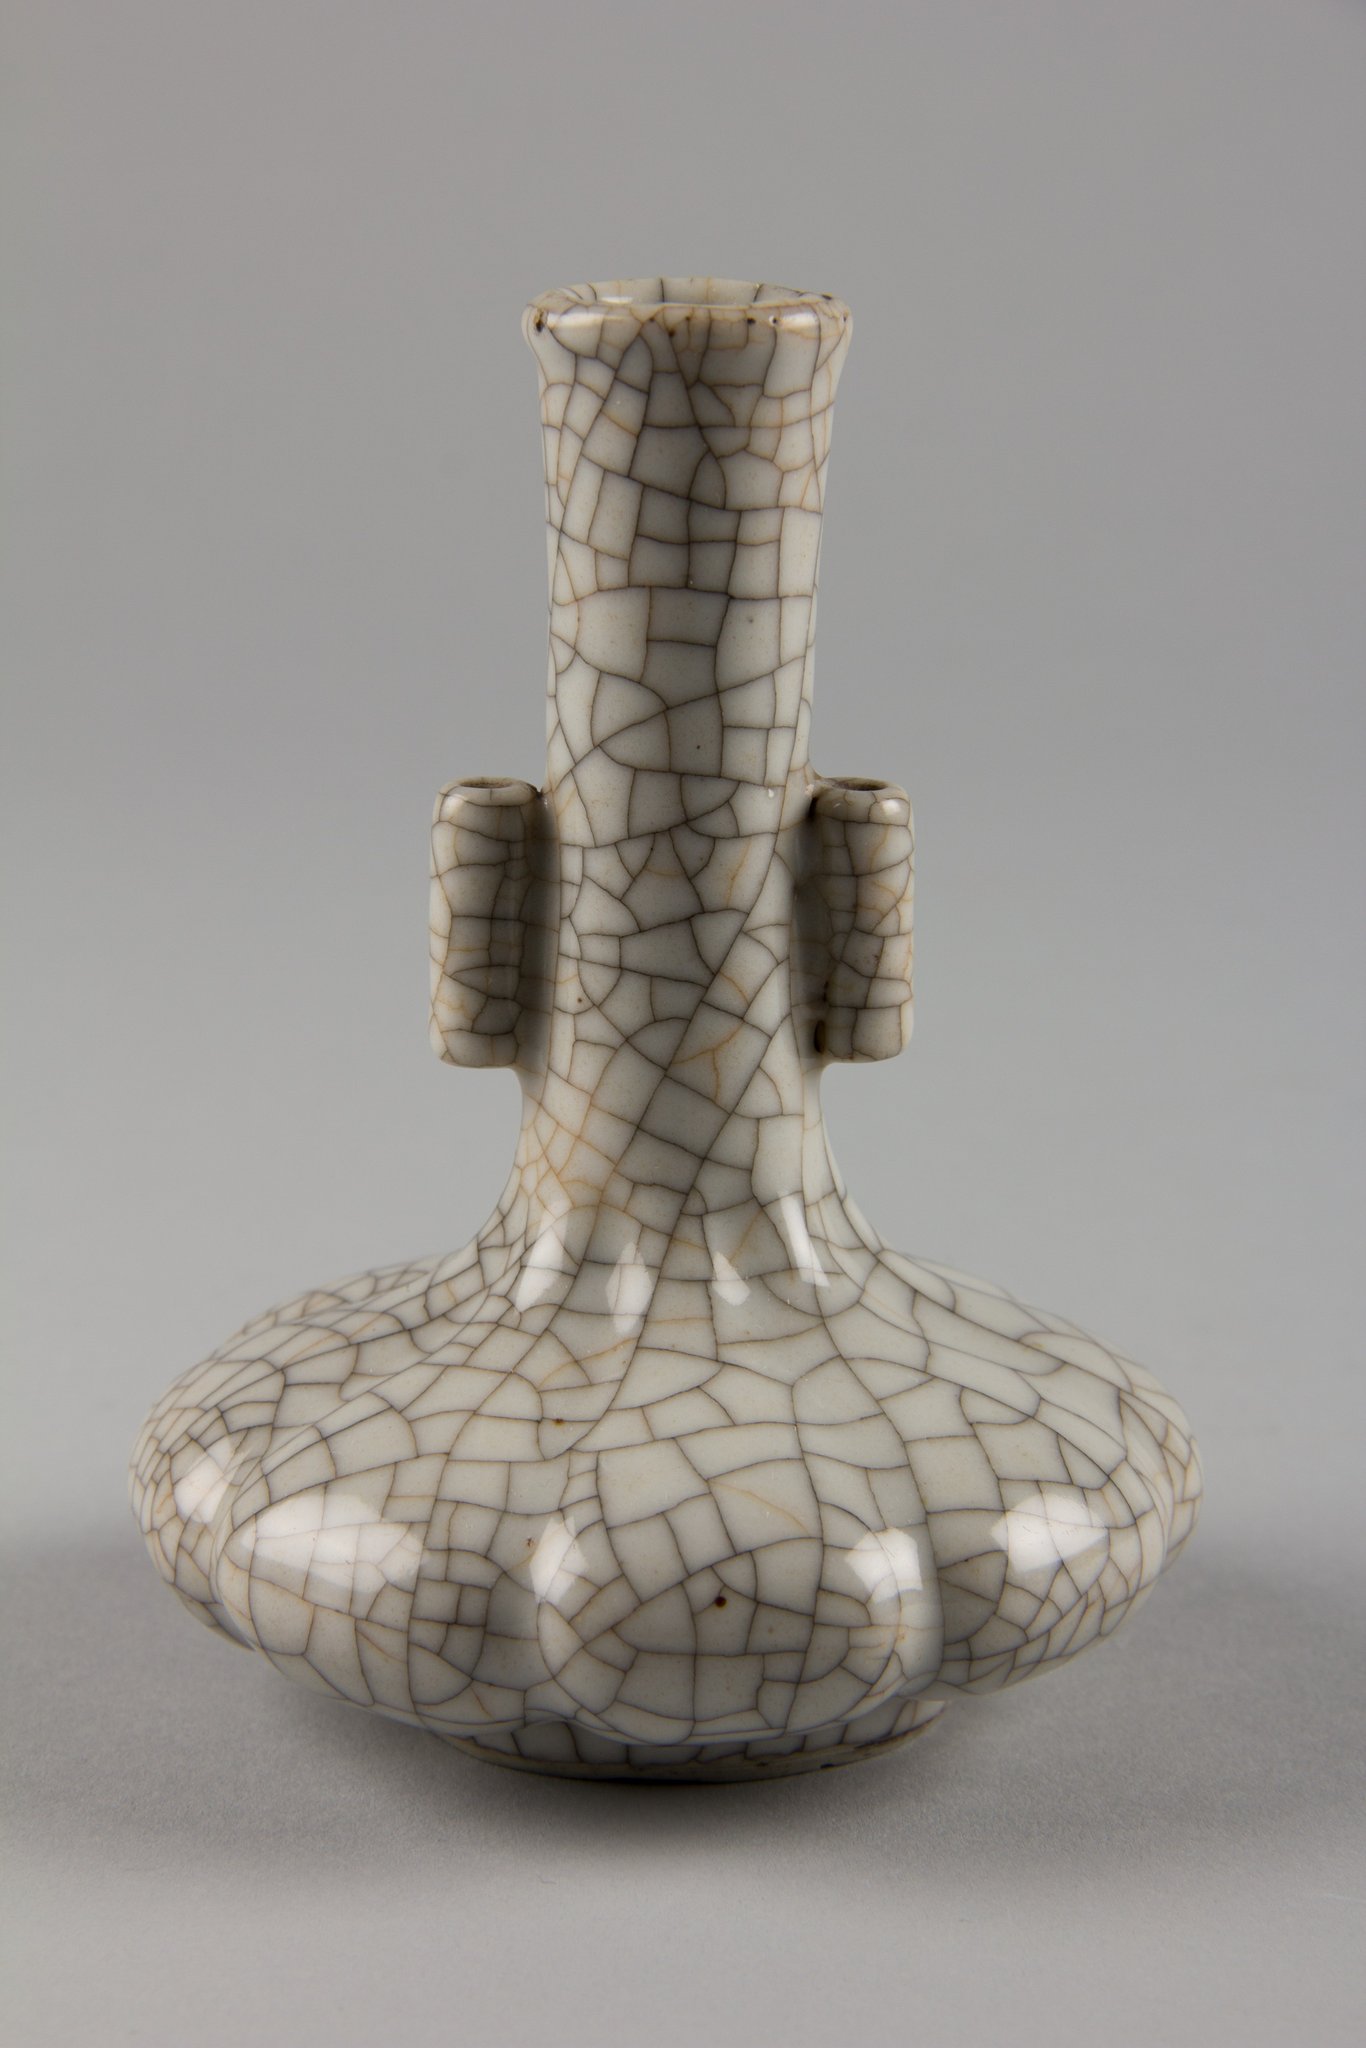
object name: vase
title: Long-neck vase with tubular handles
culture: chinese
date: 1801-1900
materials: glaze, porcelain